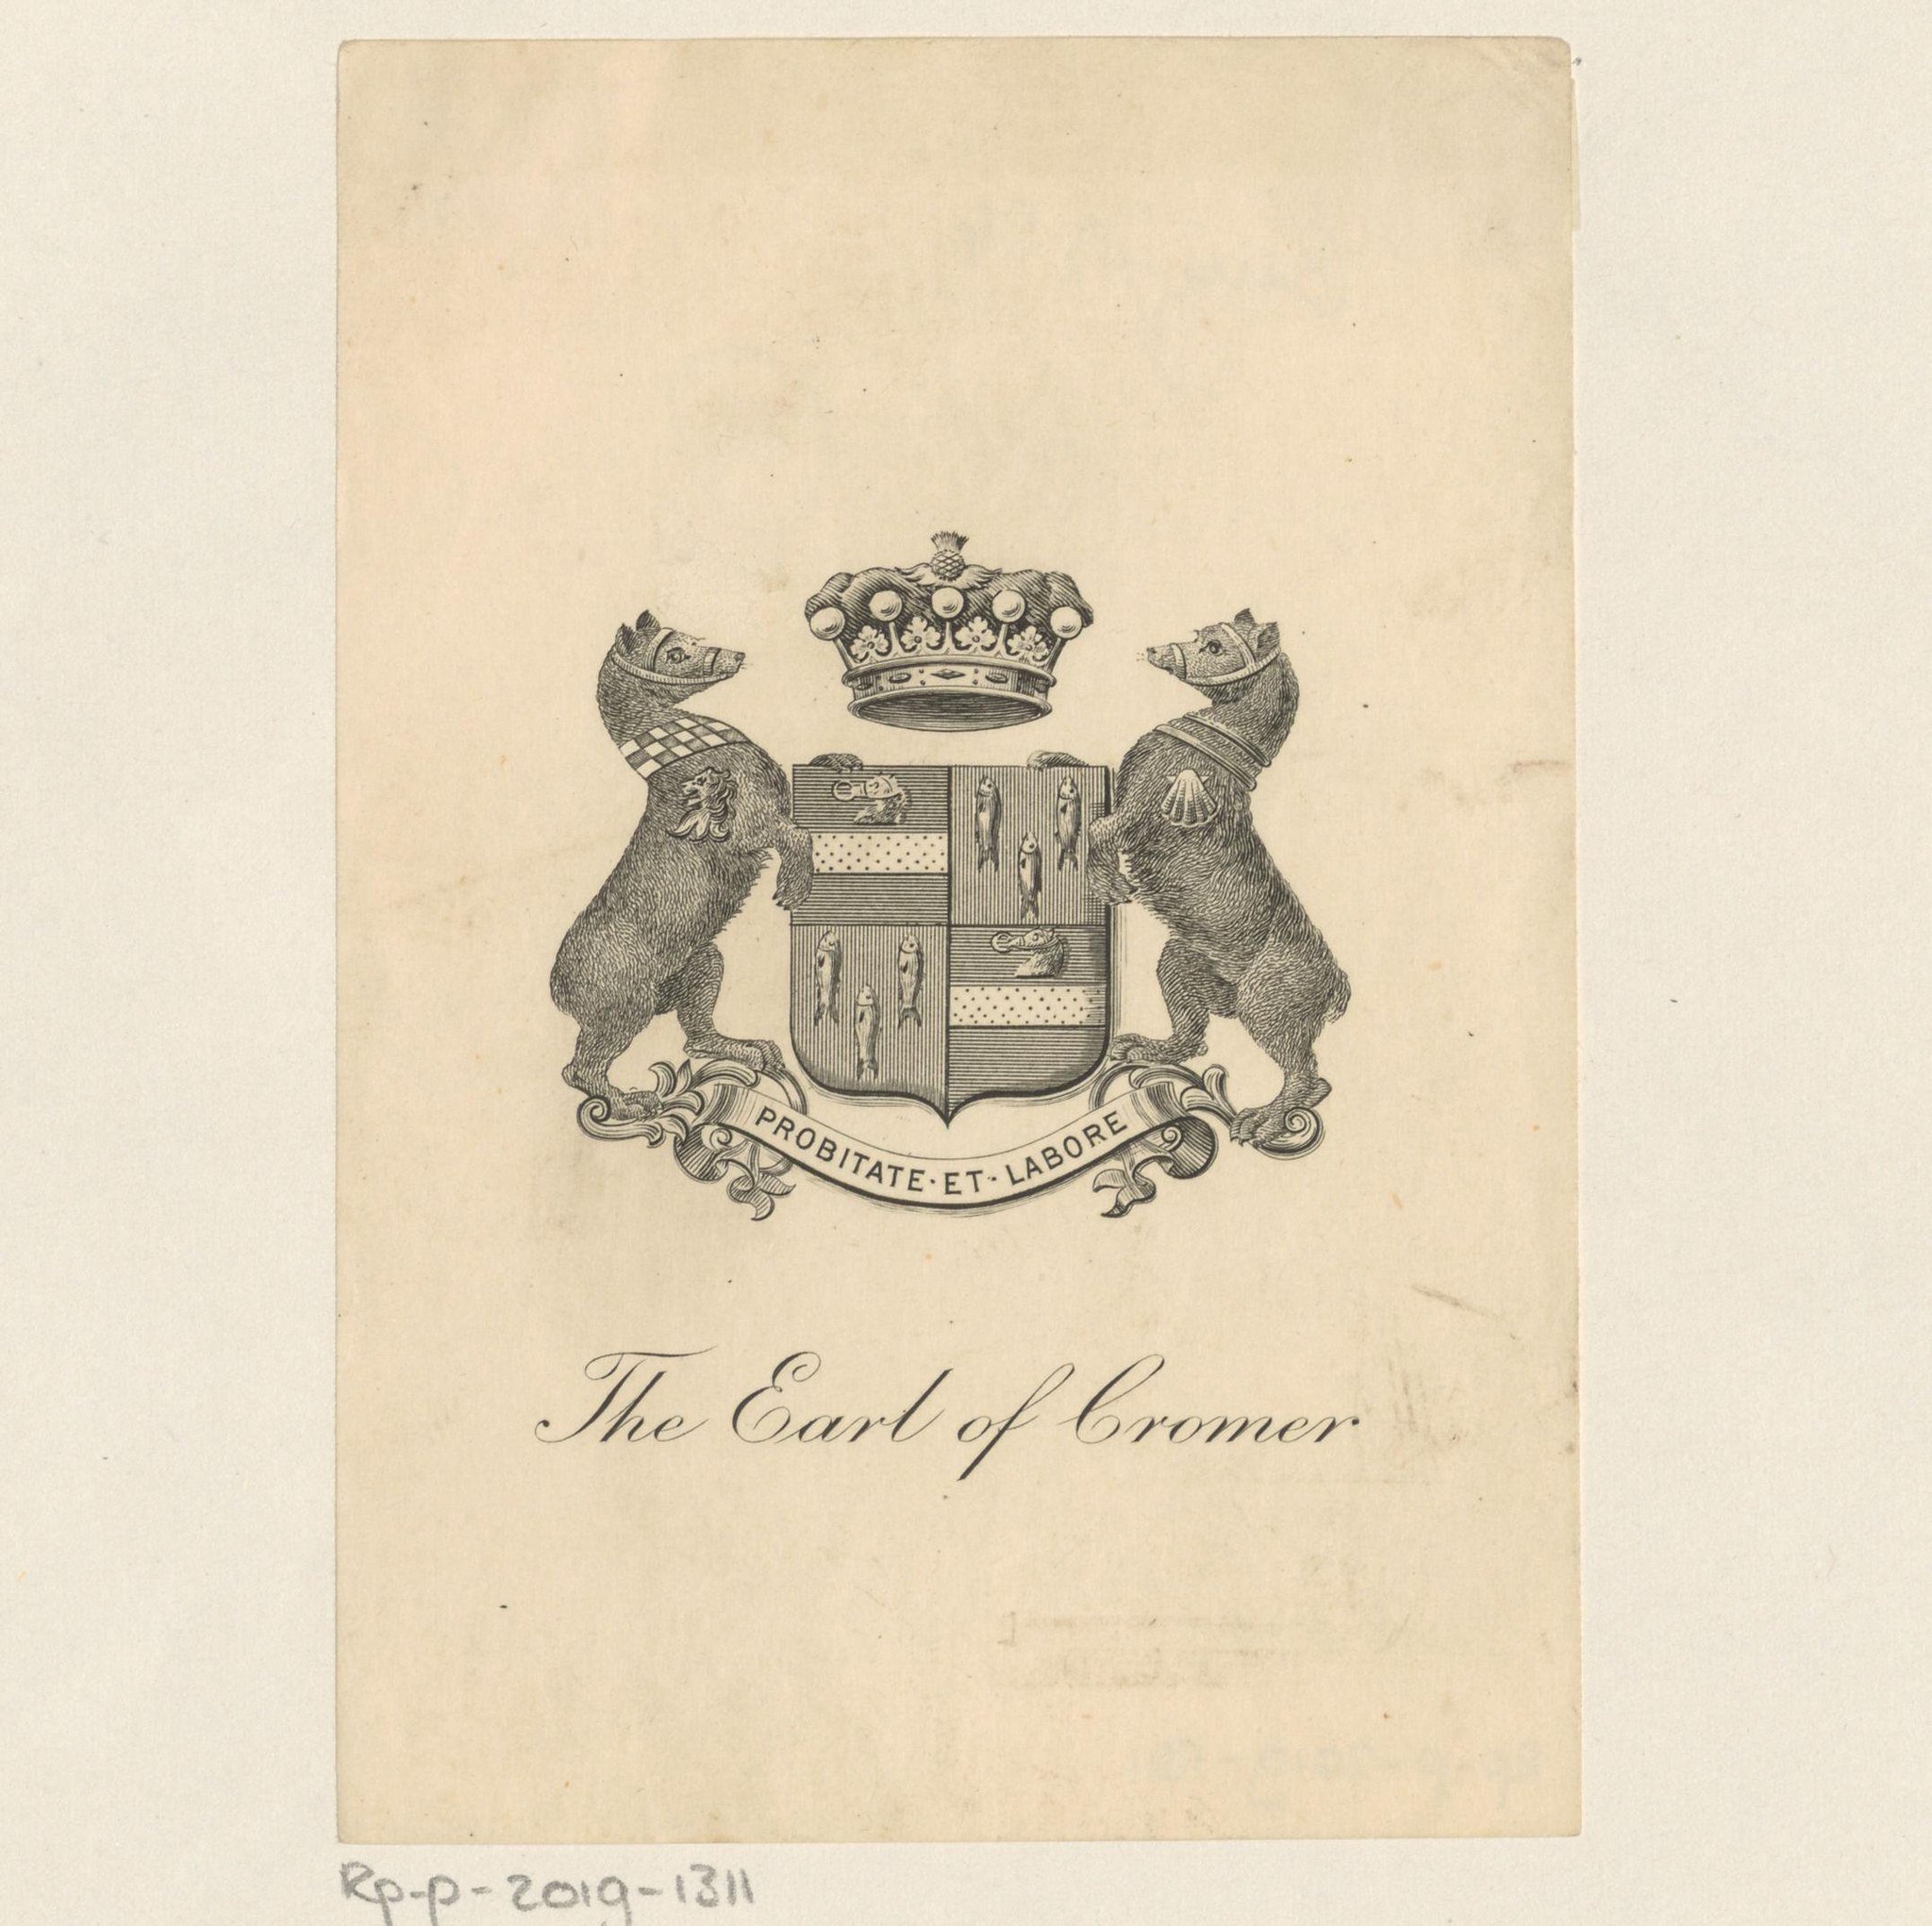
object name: bookplate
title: Probitate en labore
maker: Anonymous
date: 1800-1899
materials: paper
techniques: engraving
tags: armorial bearing, heraldry